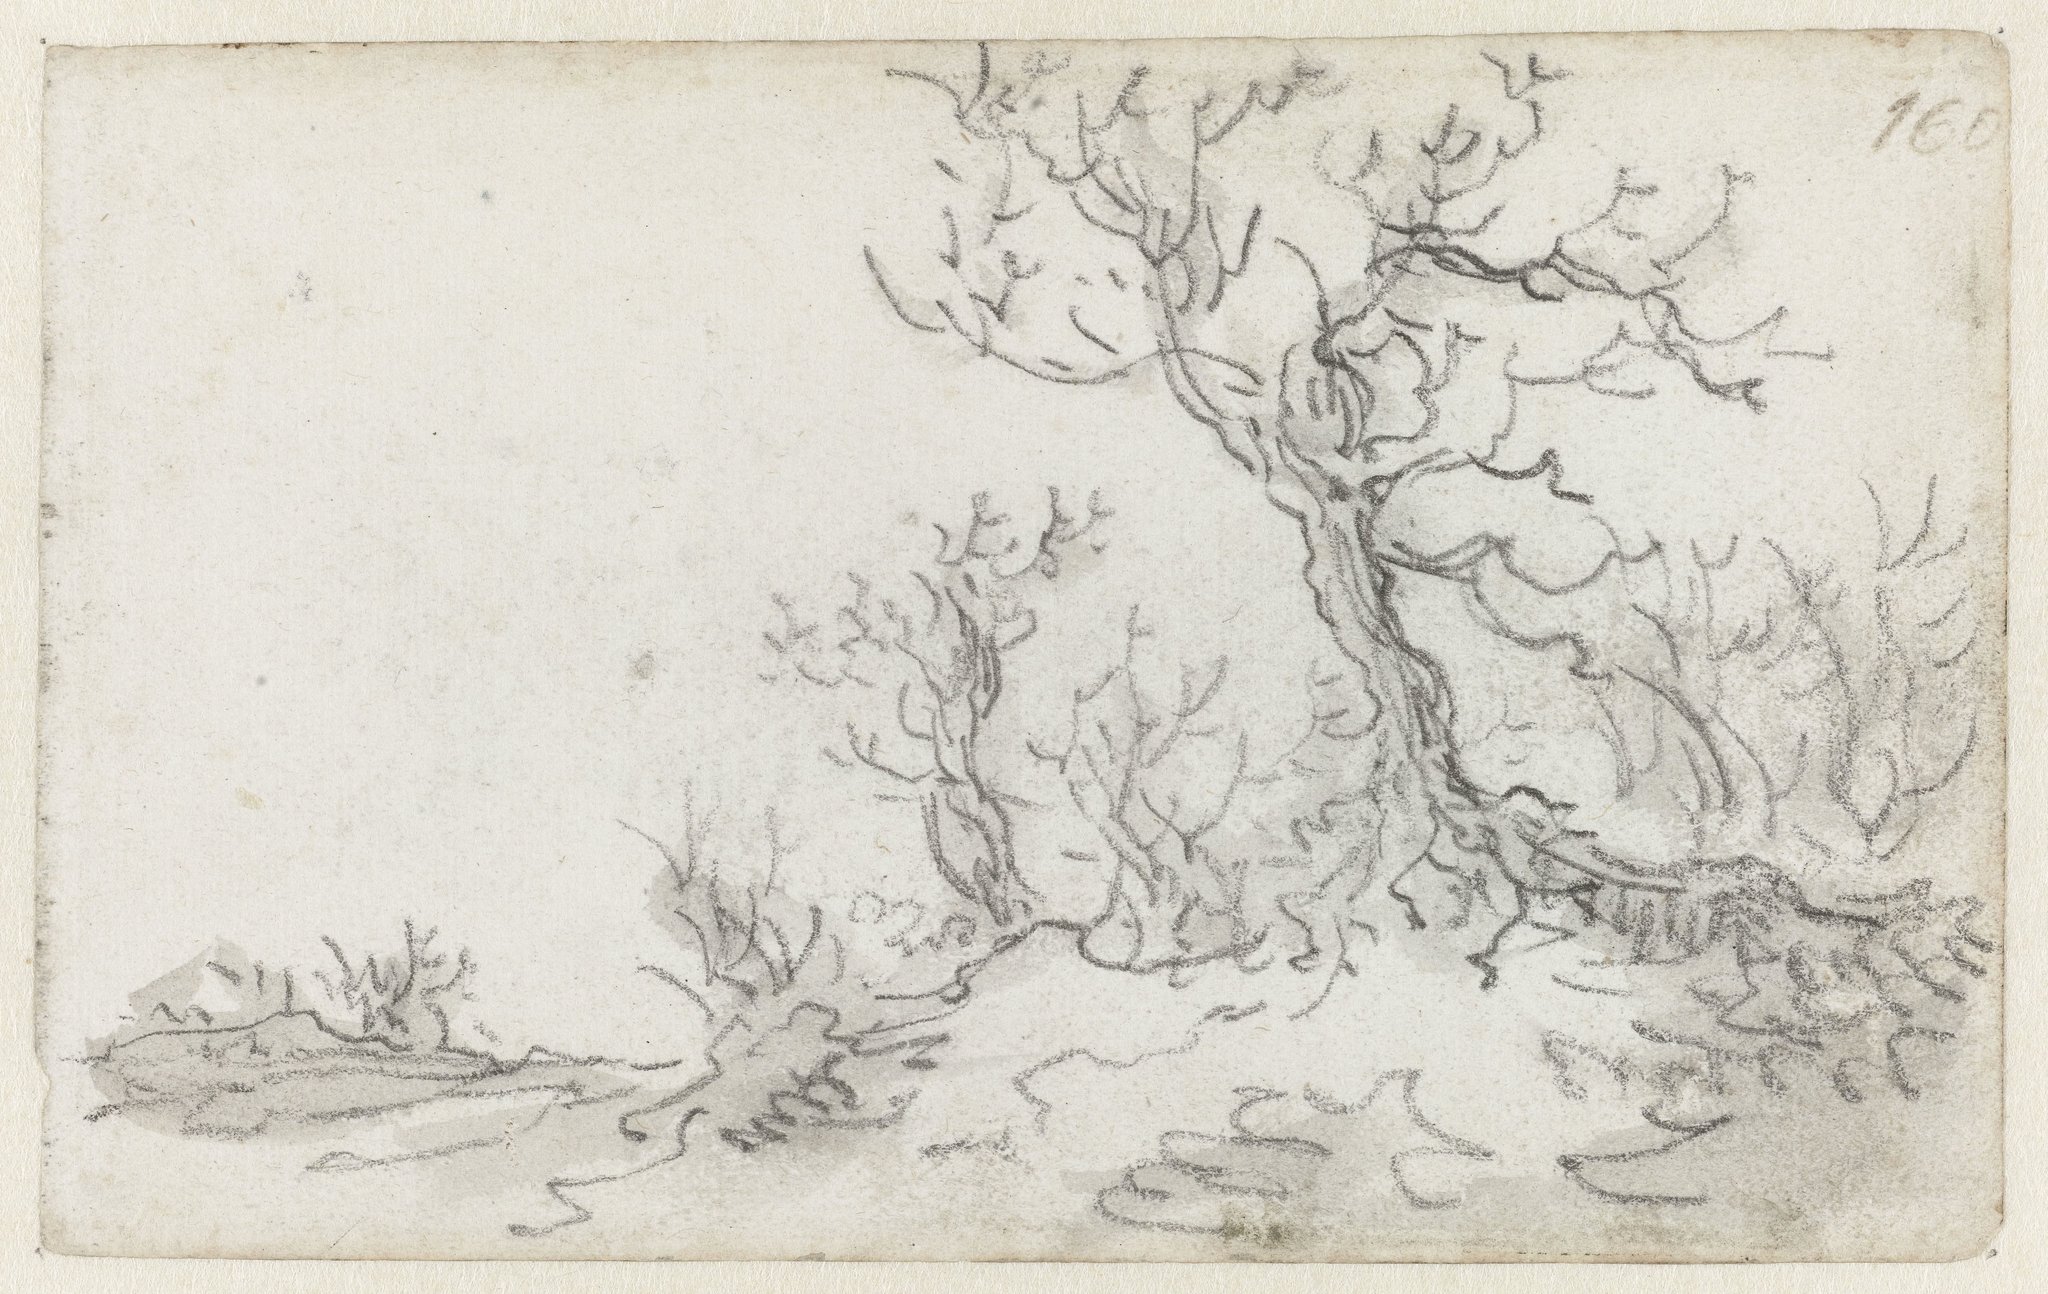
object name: drawing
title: Bare Trees by a Road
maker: jan van goyen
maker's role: draughtsman, painter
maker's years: 1596-1656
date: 1650-1651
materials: chalk, paper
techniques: brush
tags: landscapes in the temperate zone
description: Blad afkomstig uit Schetsboek van 165-1651, nr. 160c (210?).